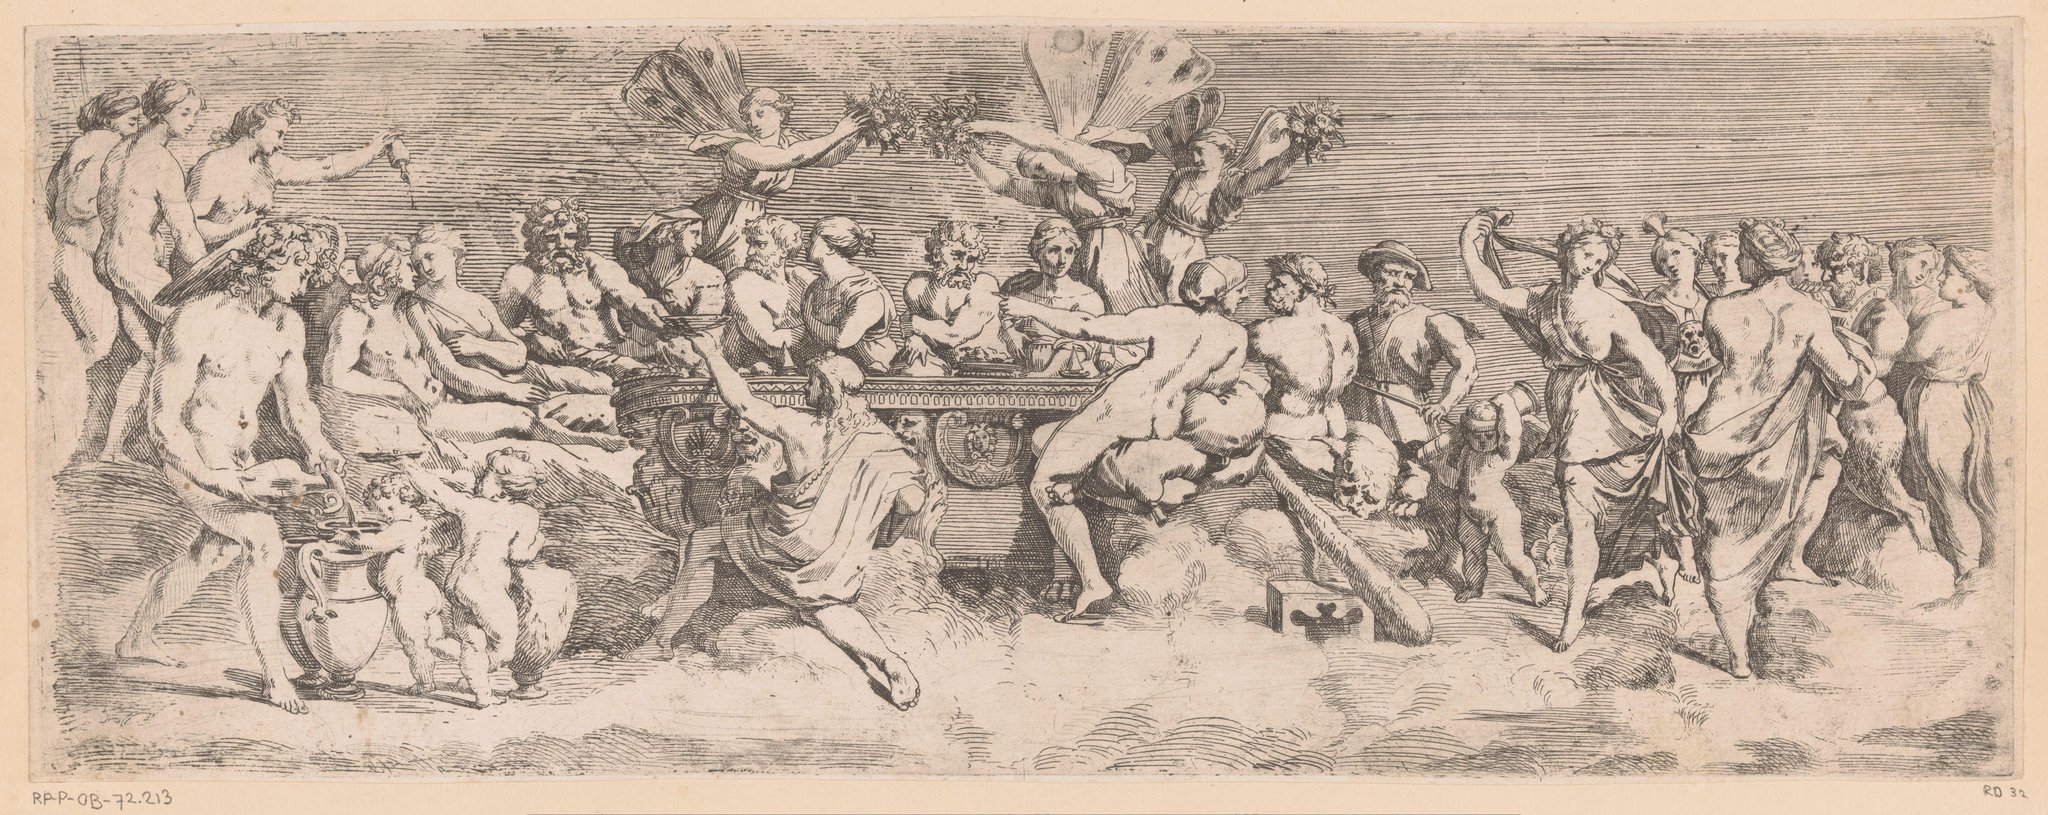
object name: print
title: Huwelijk van Psyche en Cupido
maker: françois perrier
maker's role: draughtsman, painter, print maker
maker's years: 1594-1649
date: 1590-1650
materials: paper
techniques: etching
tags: marriage of cupid and psyche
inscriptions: collector's mark: Lugt 240